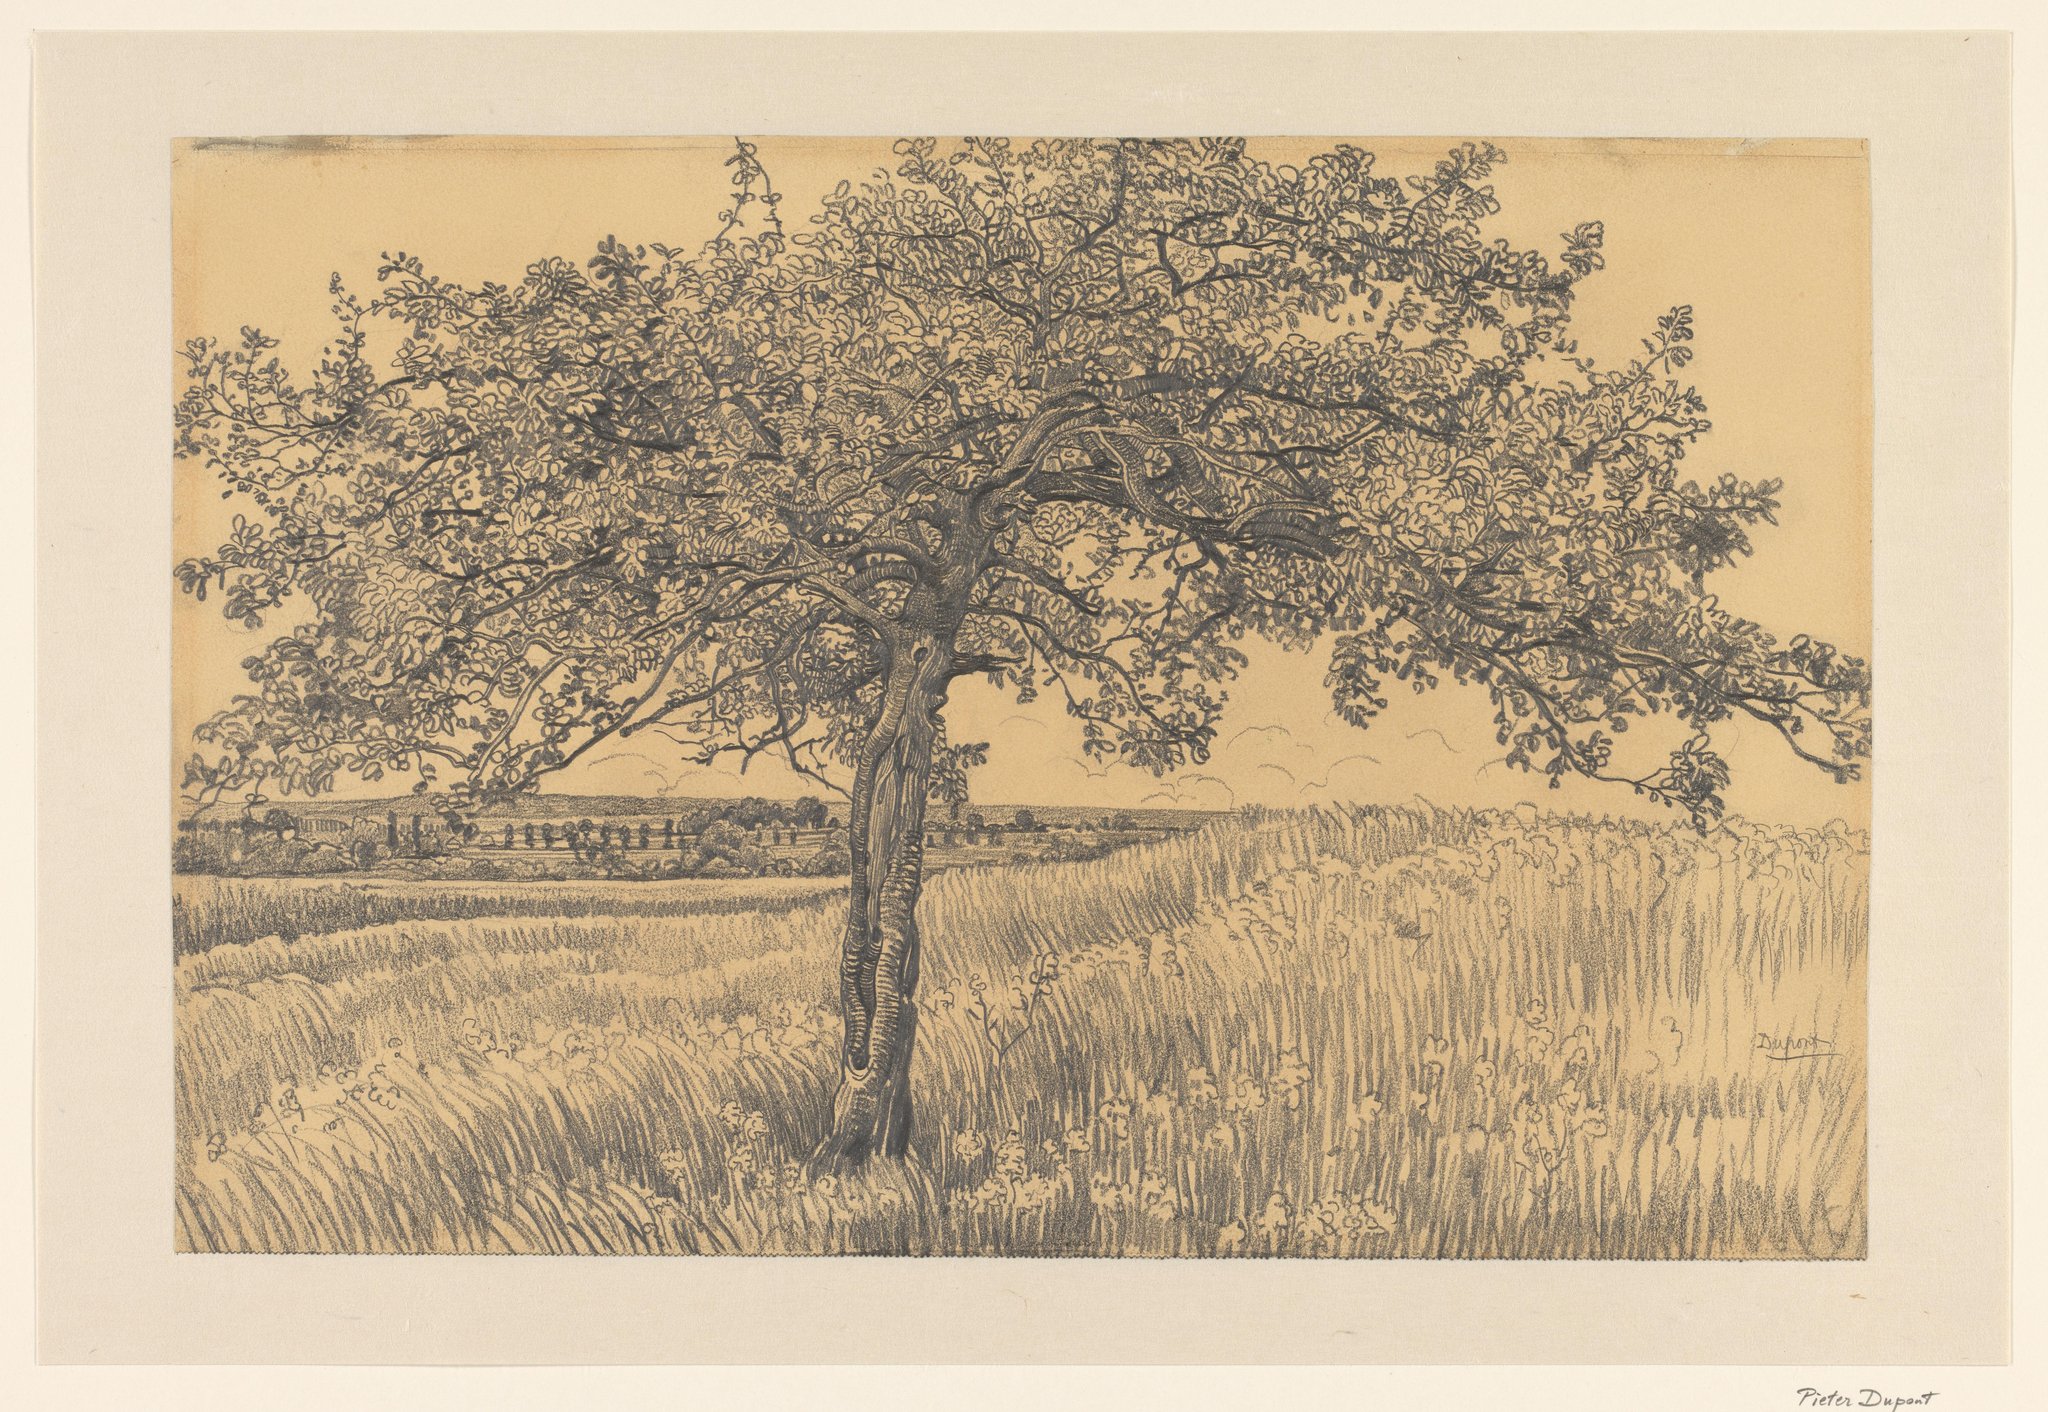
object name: drawing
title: Appelboom in landschap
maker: pieter dupont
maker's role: draughtsman, print maker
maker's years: 1870-1911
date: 1880-1911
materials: paper, pencil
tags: trees: apple-tree